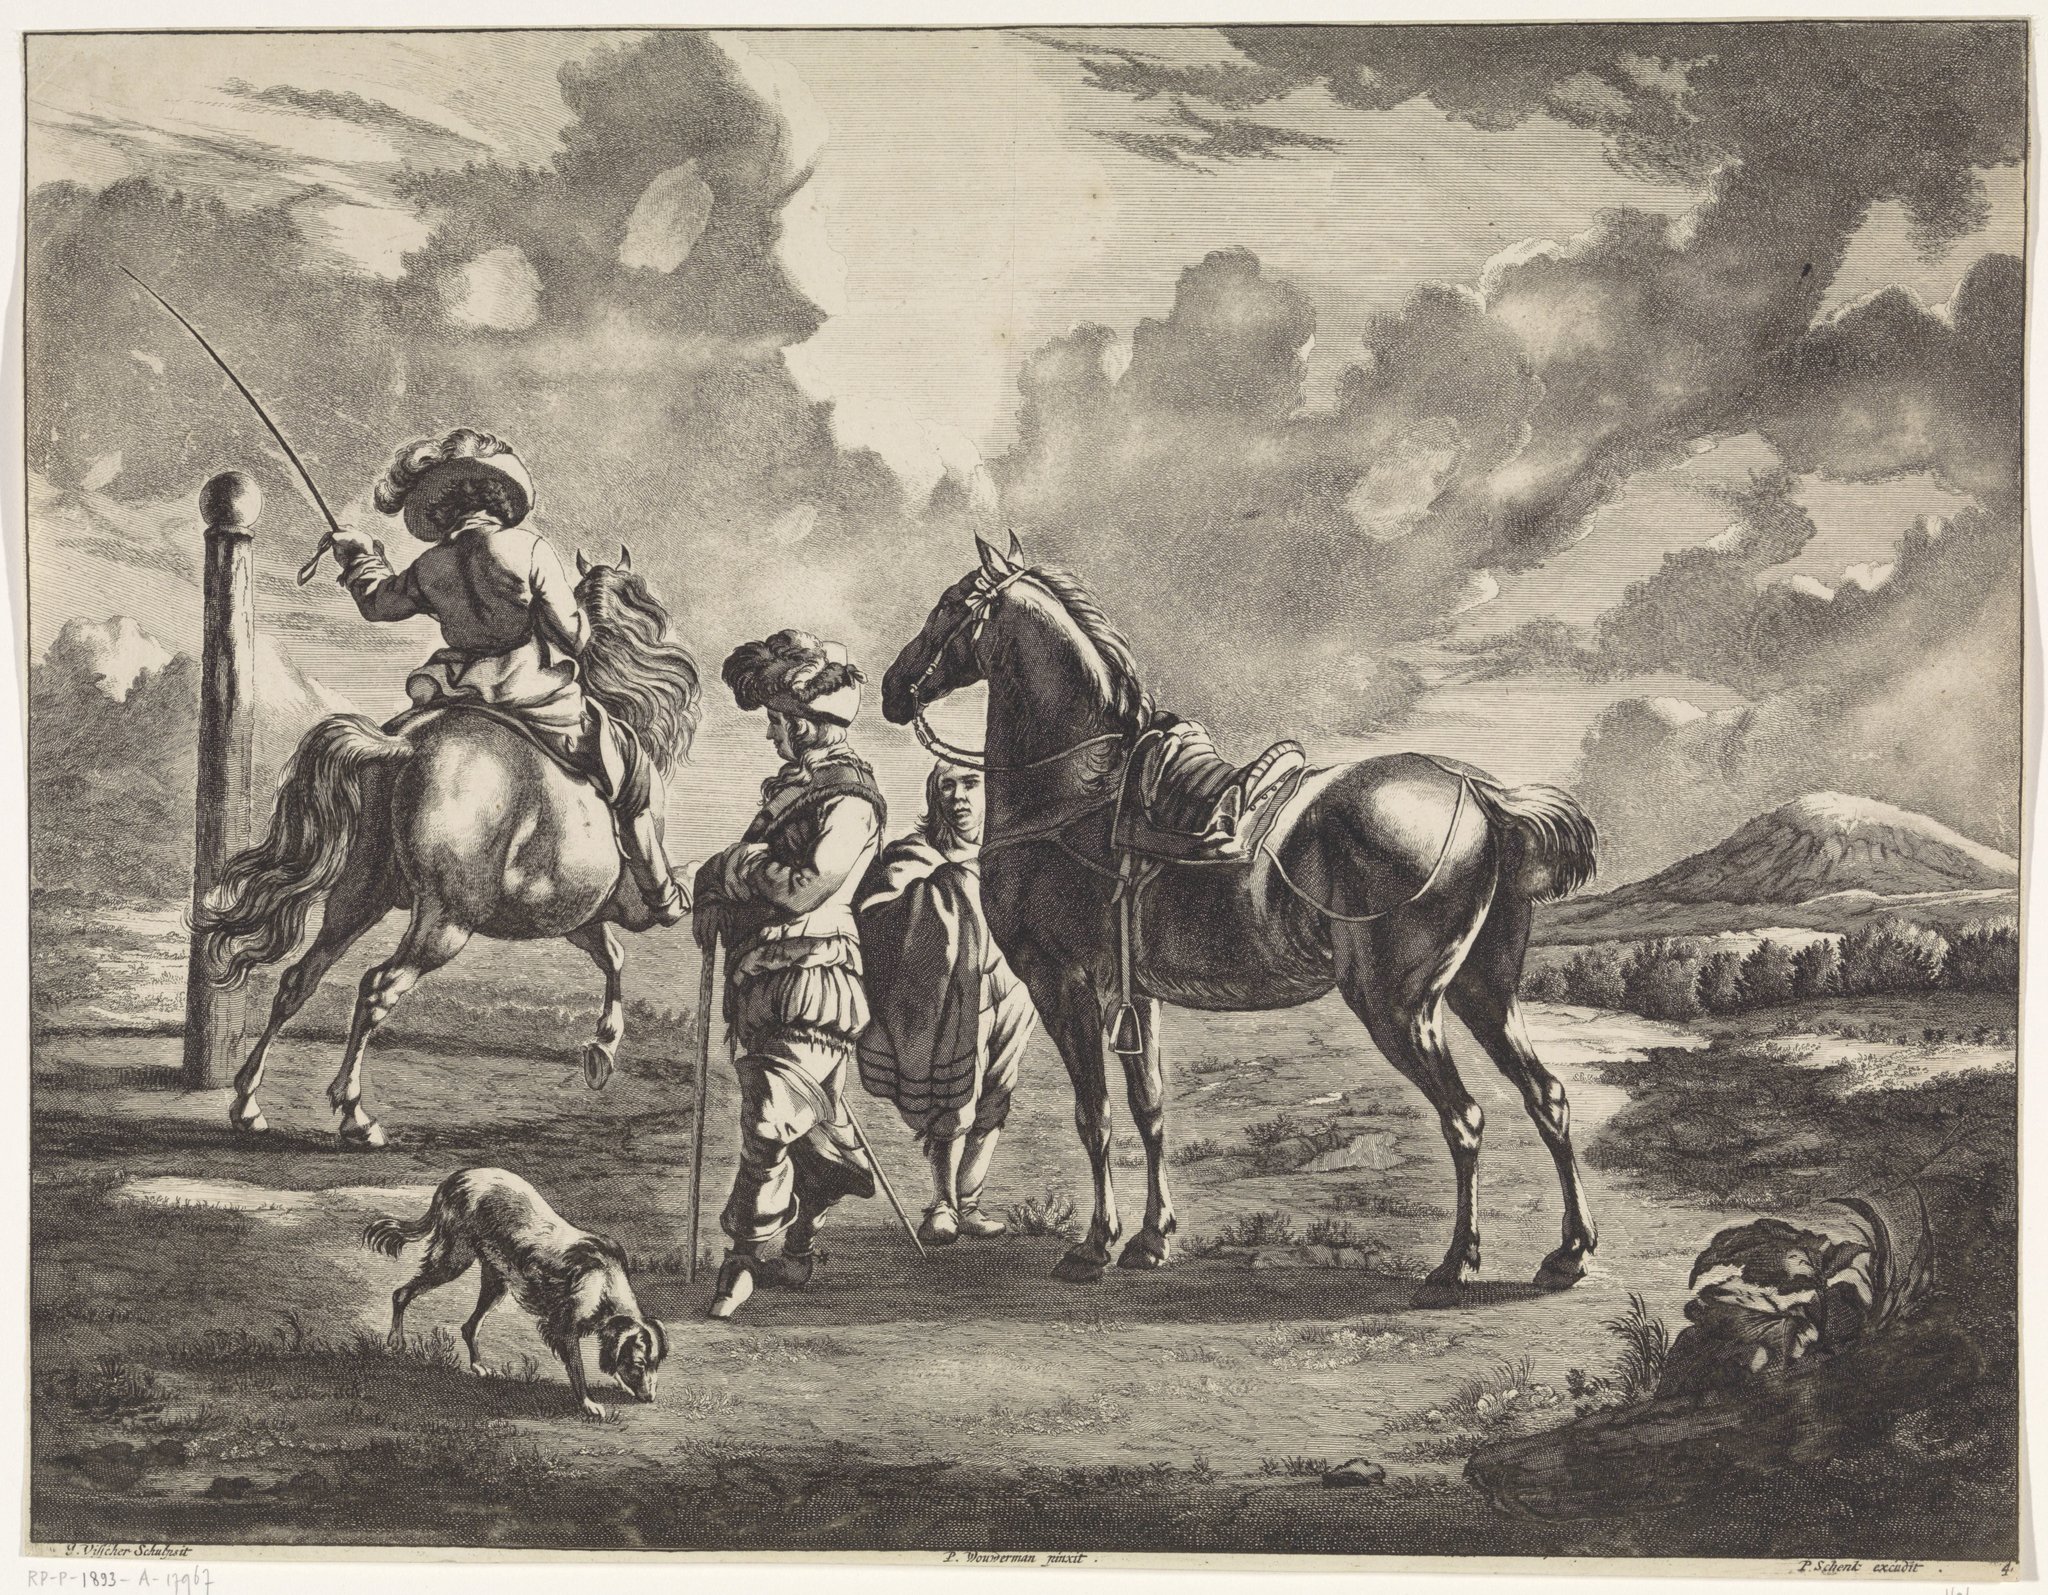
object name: print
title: Landschap met twee paarden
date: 1675-1711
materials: paper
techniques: engraving, etching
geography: northern netherlands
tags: riding a horse, ass, or mule; rider, horseman, horse, dog, whip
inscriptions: collector's mark: Lugt 2228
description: In een landschap staan twee mannen bij een gezadeld paard te kijken naar een ruiter die met zijn ros om een paal rijdt.